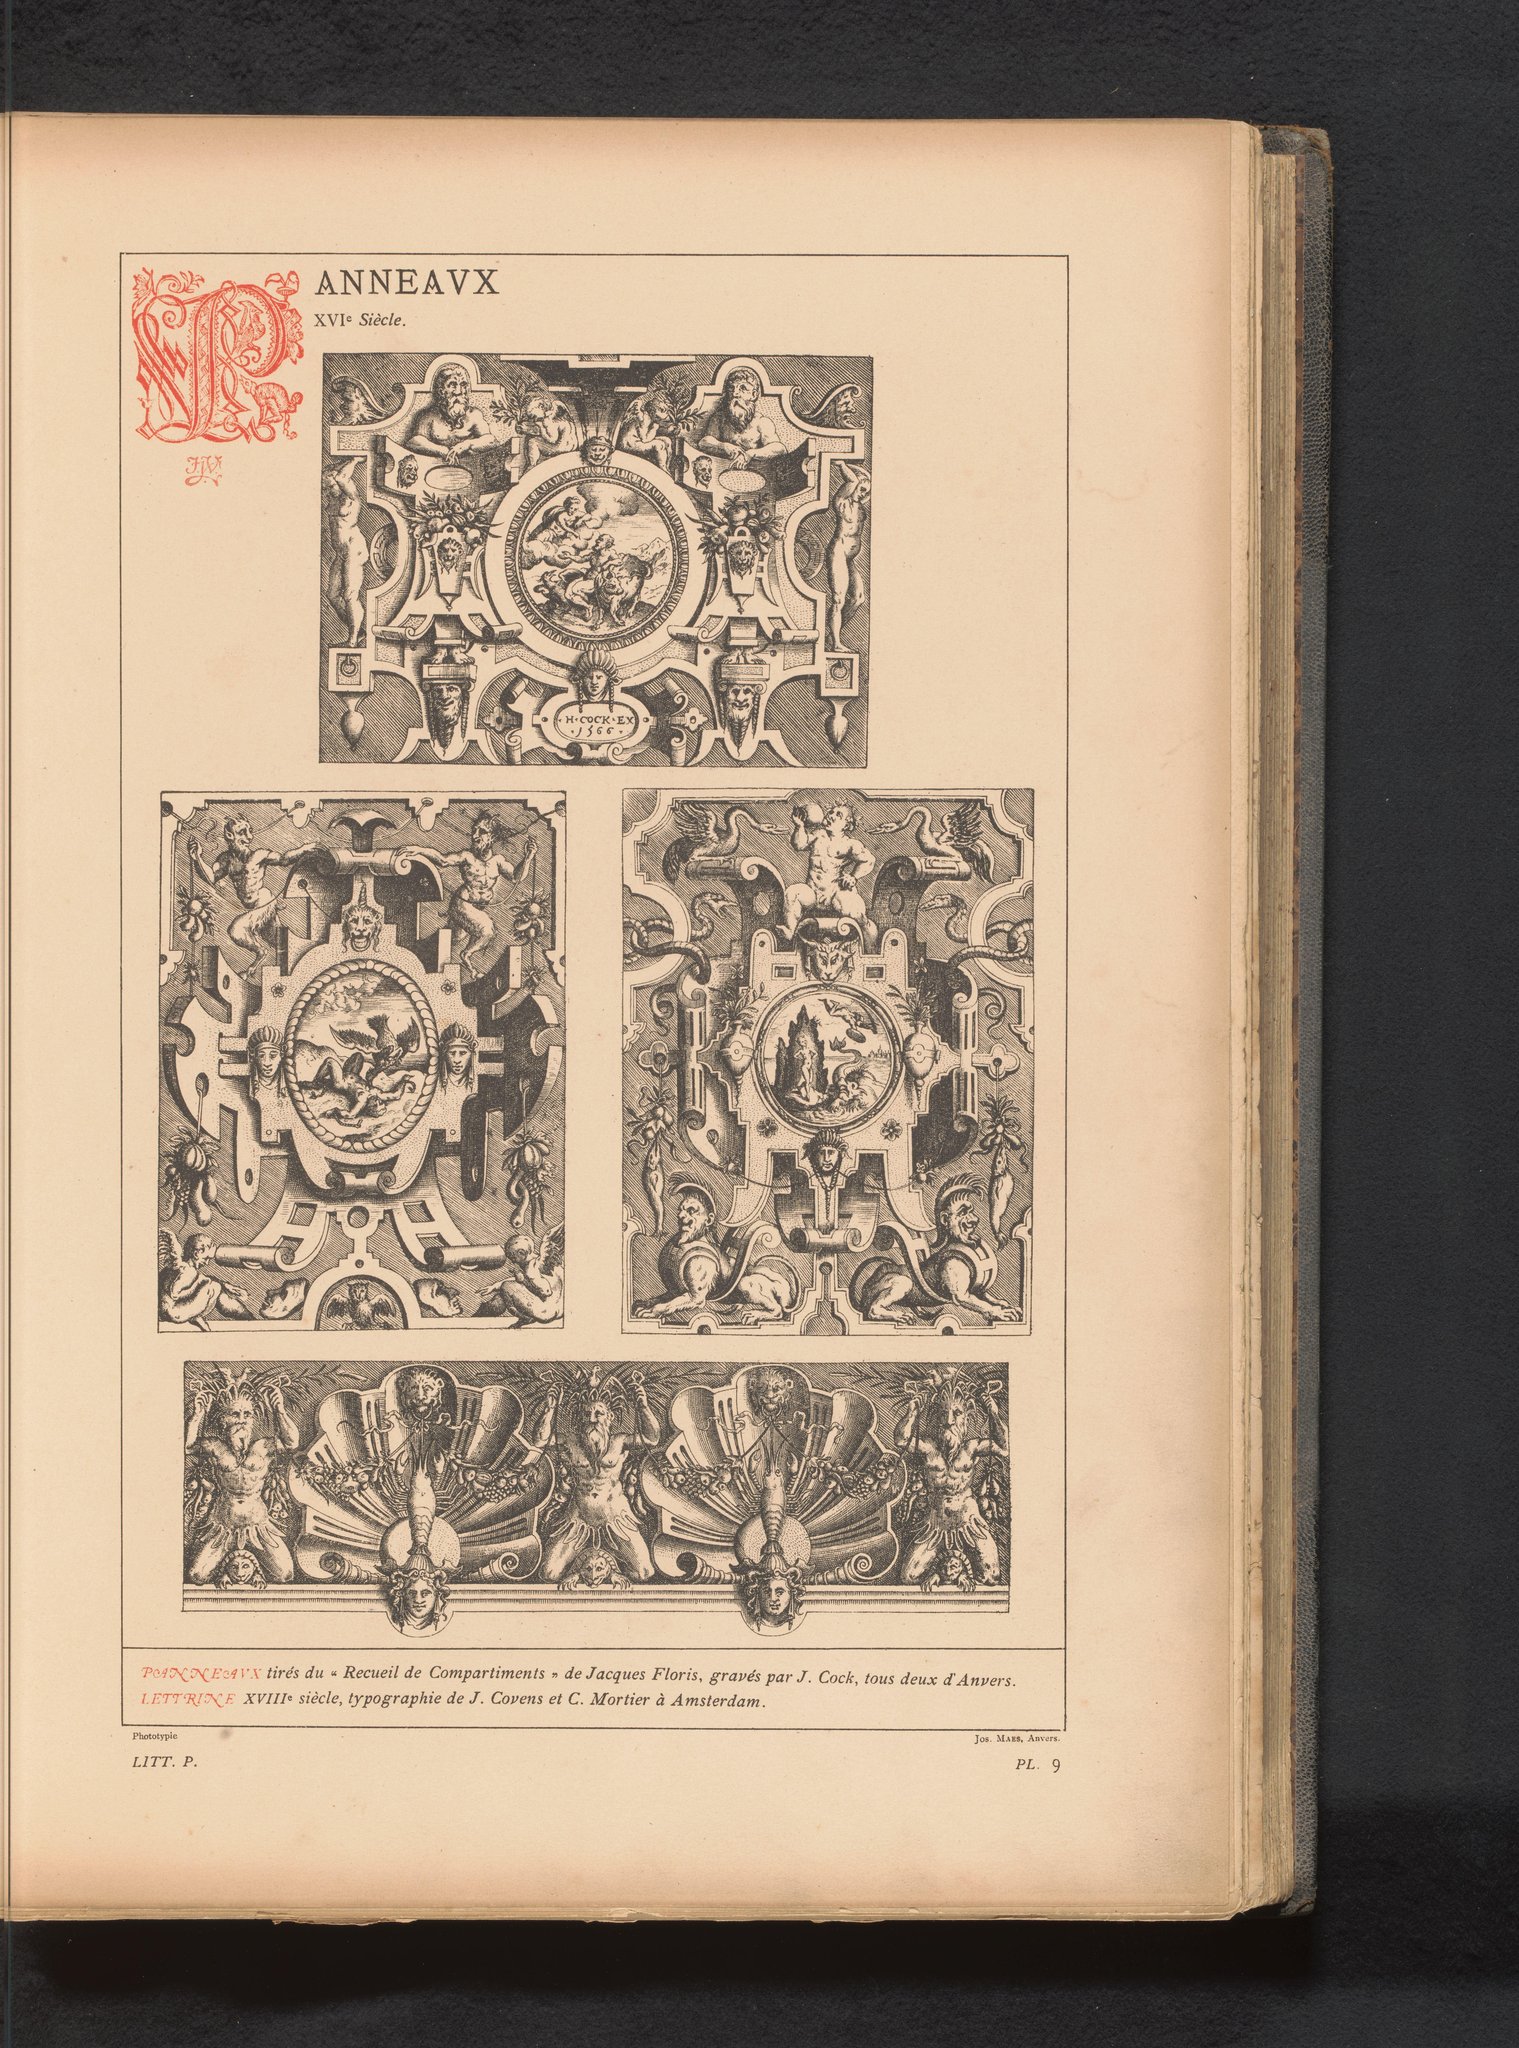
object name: page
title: Reproductie van een prent van gedecoreerde panelen door Hieronymus Cock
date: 1876-1881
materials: paper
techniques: photolithography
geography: antwerp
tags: fabulous animals ~ predatory animals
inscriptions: inscription: ‘PANNEAUX tirés du (...)’, inscription: ‘LITT. P. - PL. 9.’, monogram: ‘JJvY’